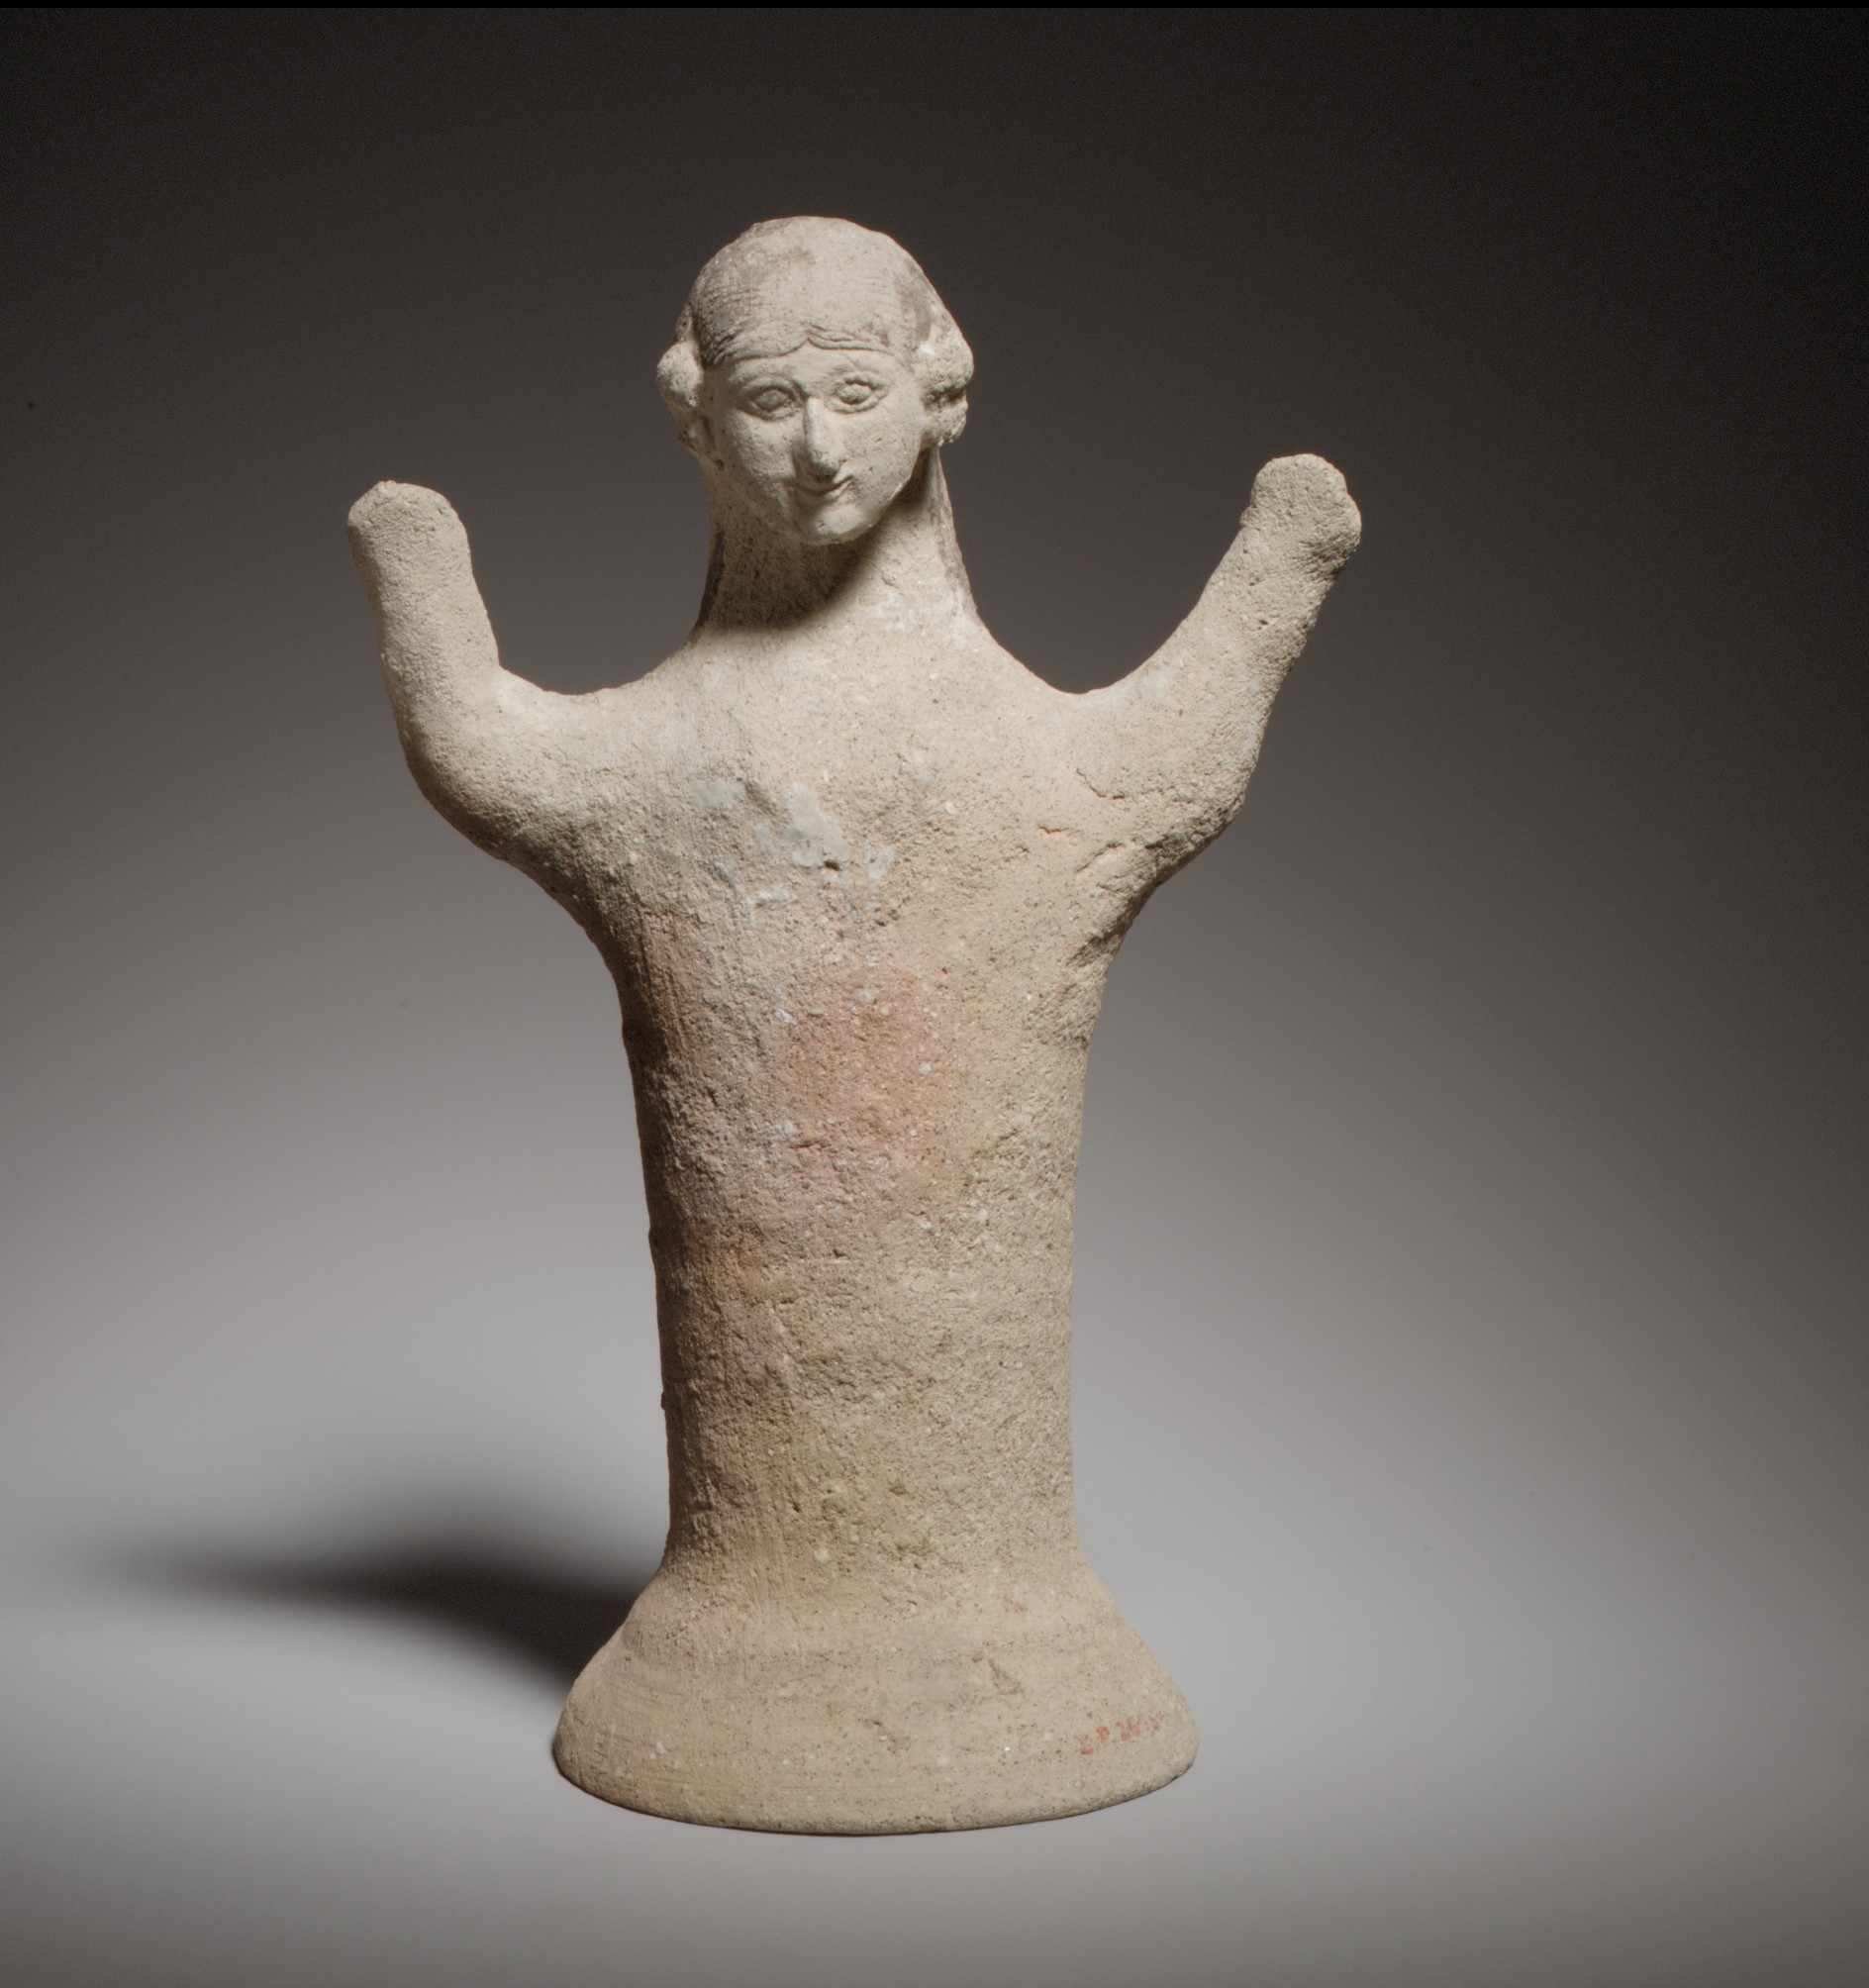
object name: statuette of a woman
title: Terracotta statuette of a woman with raised arms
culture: cypriot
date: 600-480 BCE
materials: terracotta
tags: women